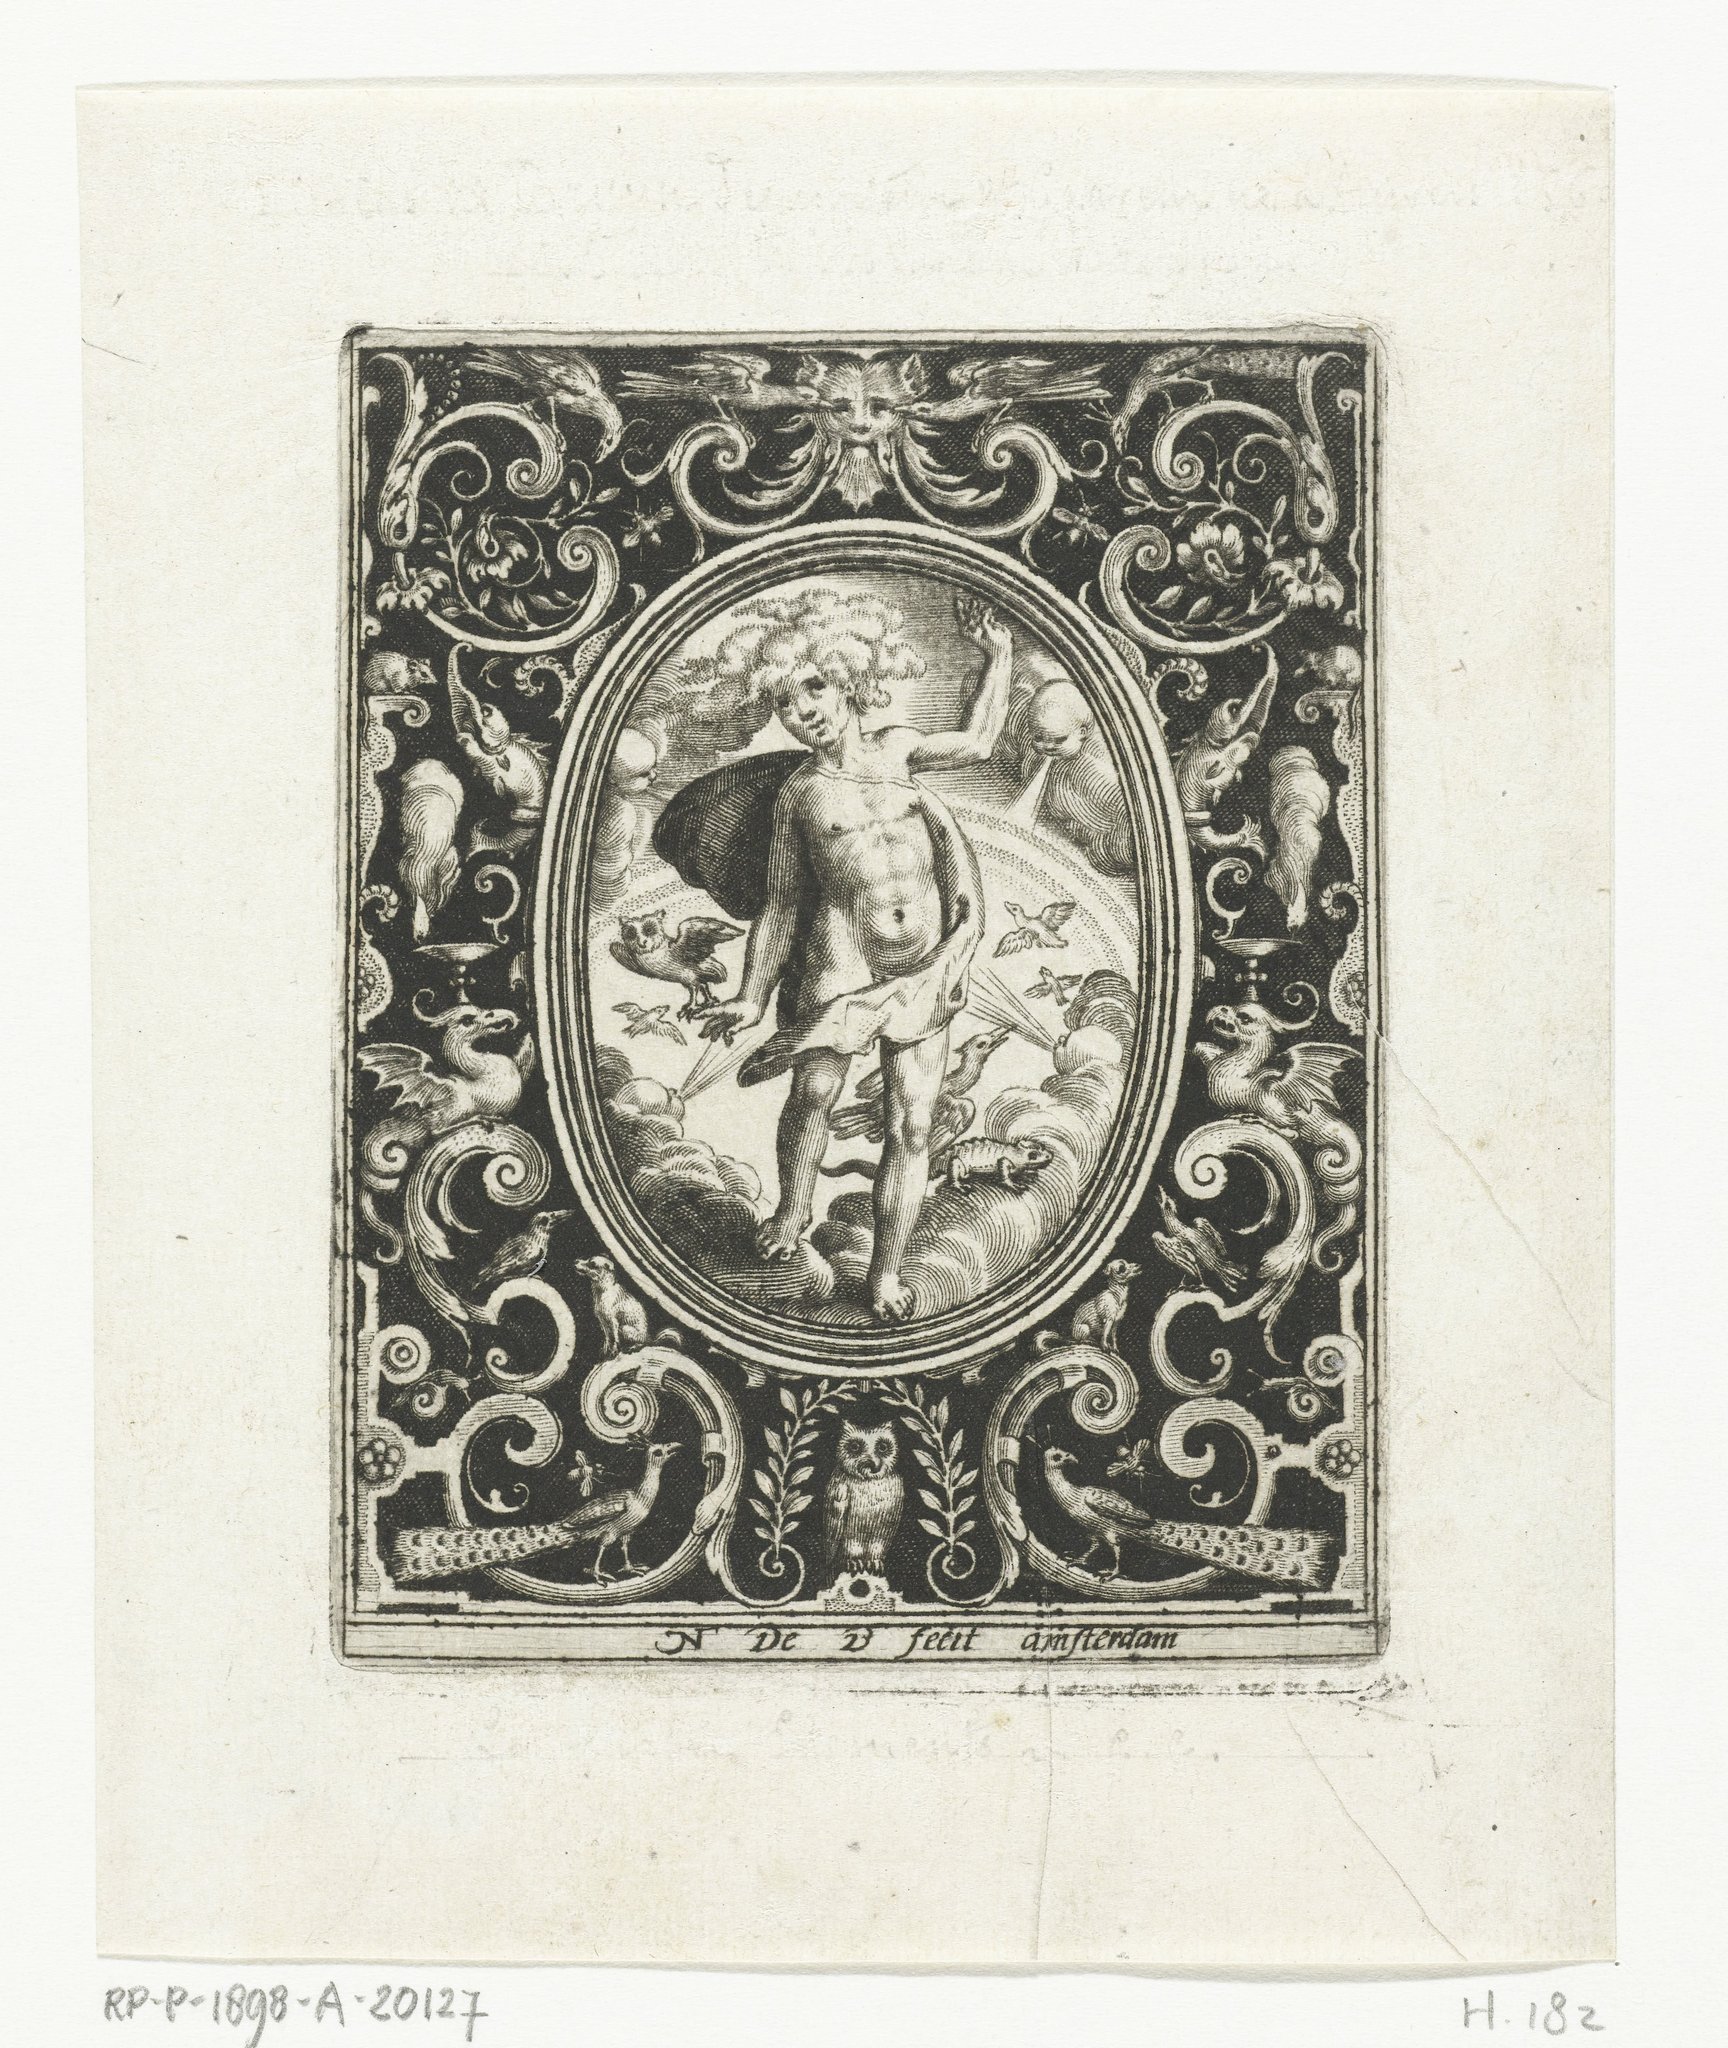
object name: print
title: Vier elementen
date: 1581-1656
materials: paper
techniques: engraving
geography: amsterdam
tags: air (one of the four elements), owls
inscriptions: collector's mark: Lugt 2228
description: Prent uit serie van vier prenten met de Vier elementen. De drukplaten zijn voor deze serie opnieuw gebruikt, vergelijk de serie van vier deugden waarbij de omlijsting met ornamenten identiek is (Hollstein nrs. 178-181). Het lijkt er op dat de platen voor de vier elementen werden opgewerkt want de donkere achtergrond is zwaarder geëtst.